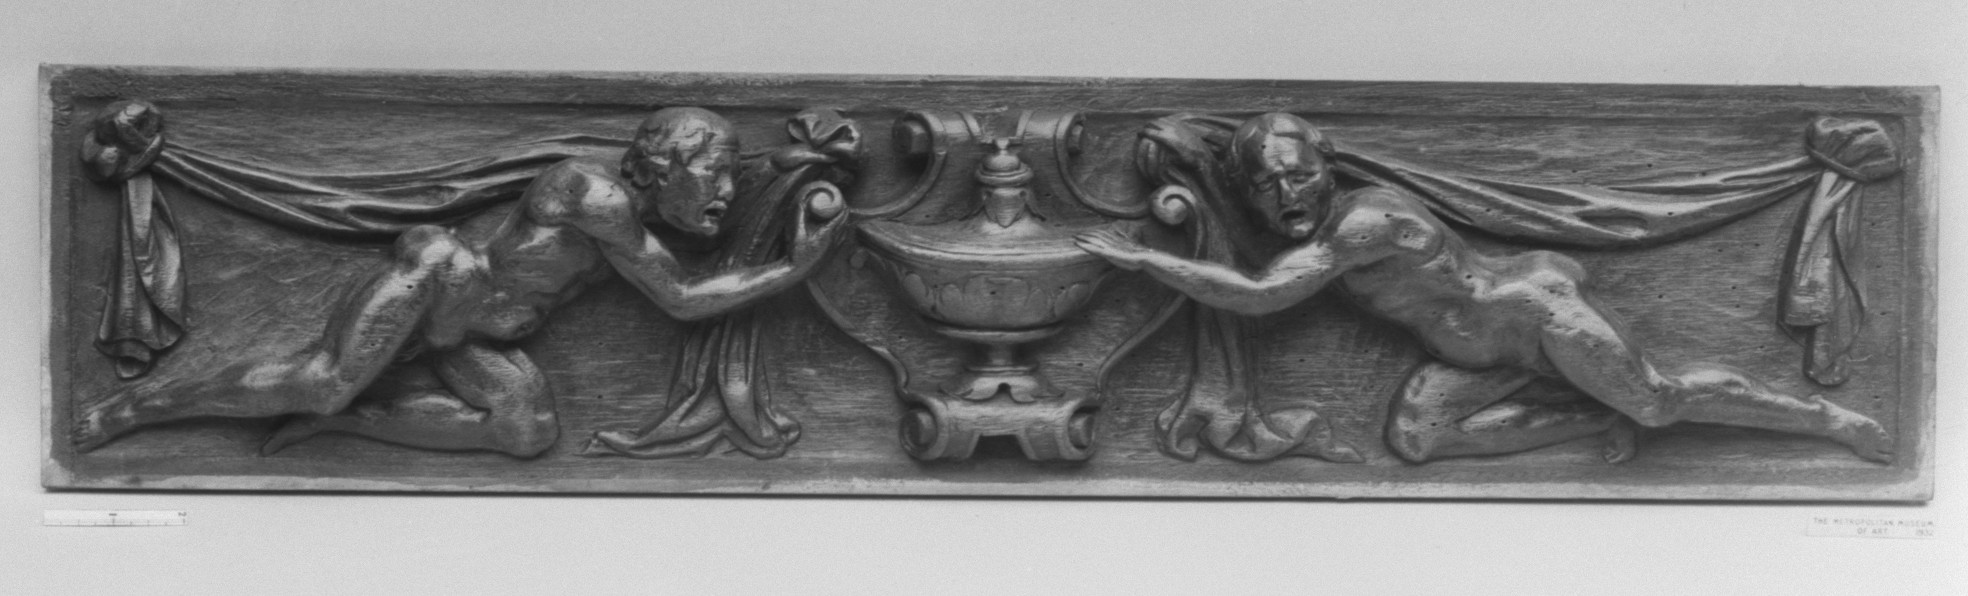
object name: panel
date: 1501-1600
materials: wood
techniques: carving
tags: male nudes